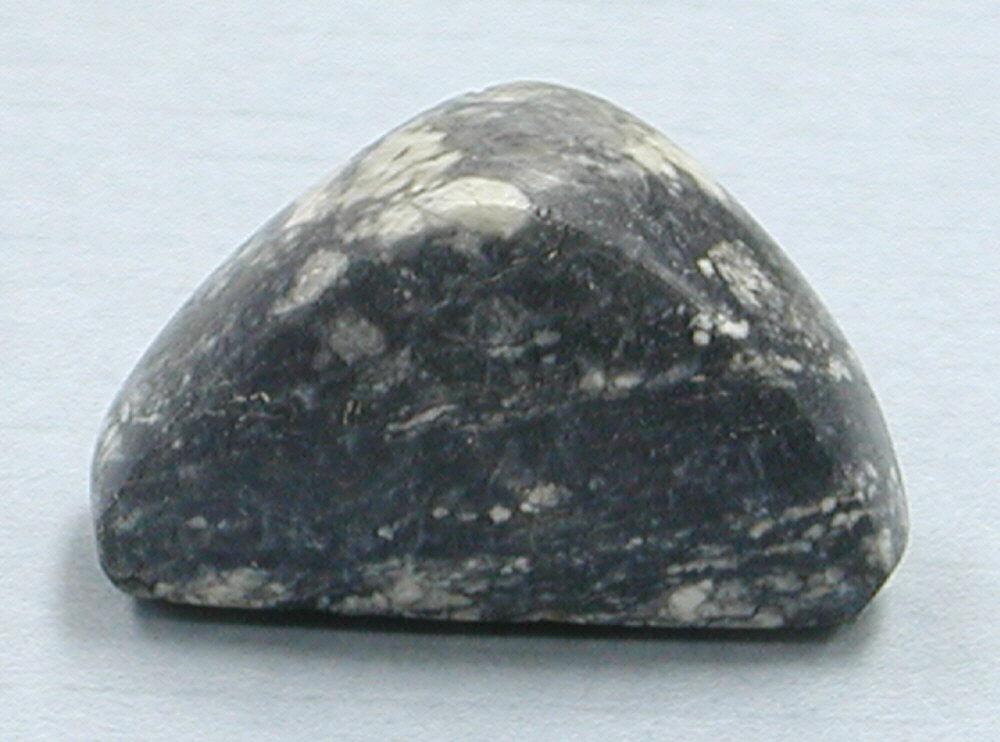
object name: ritual stone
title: Stone Pulidor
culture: mexican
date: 1501-1600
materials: stone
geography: mexico